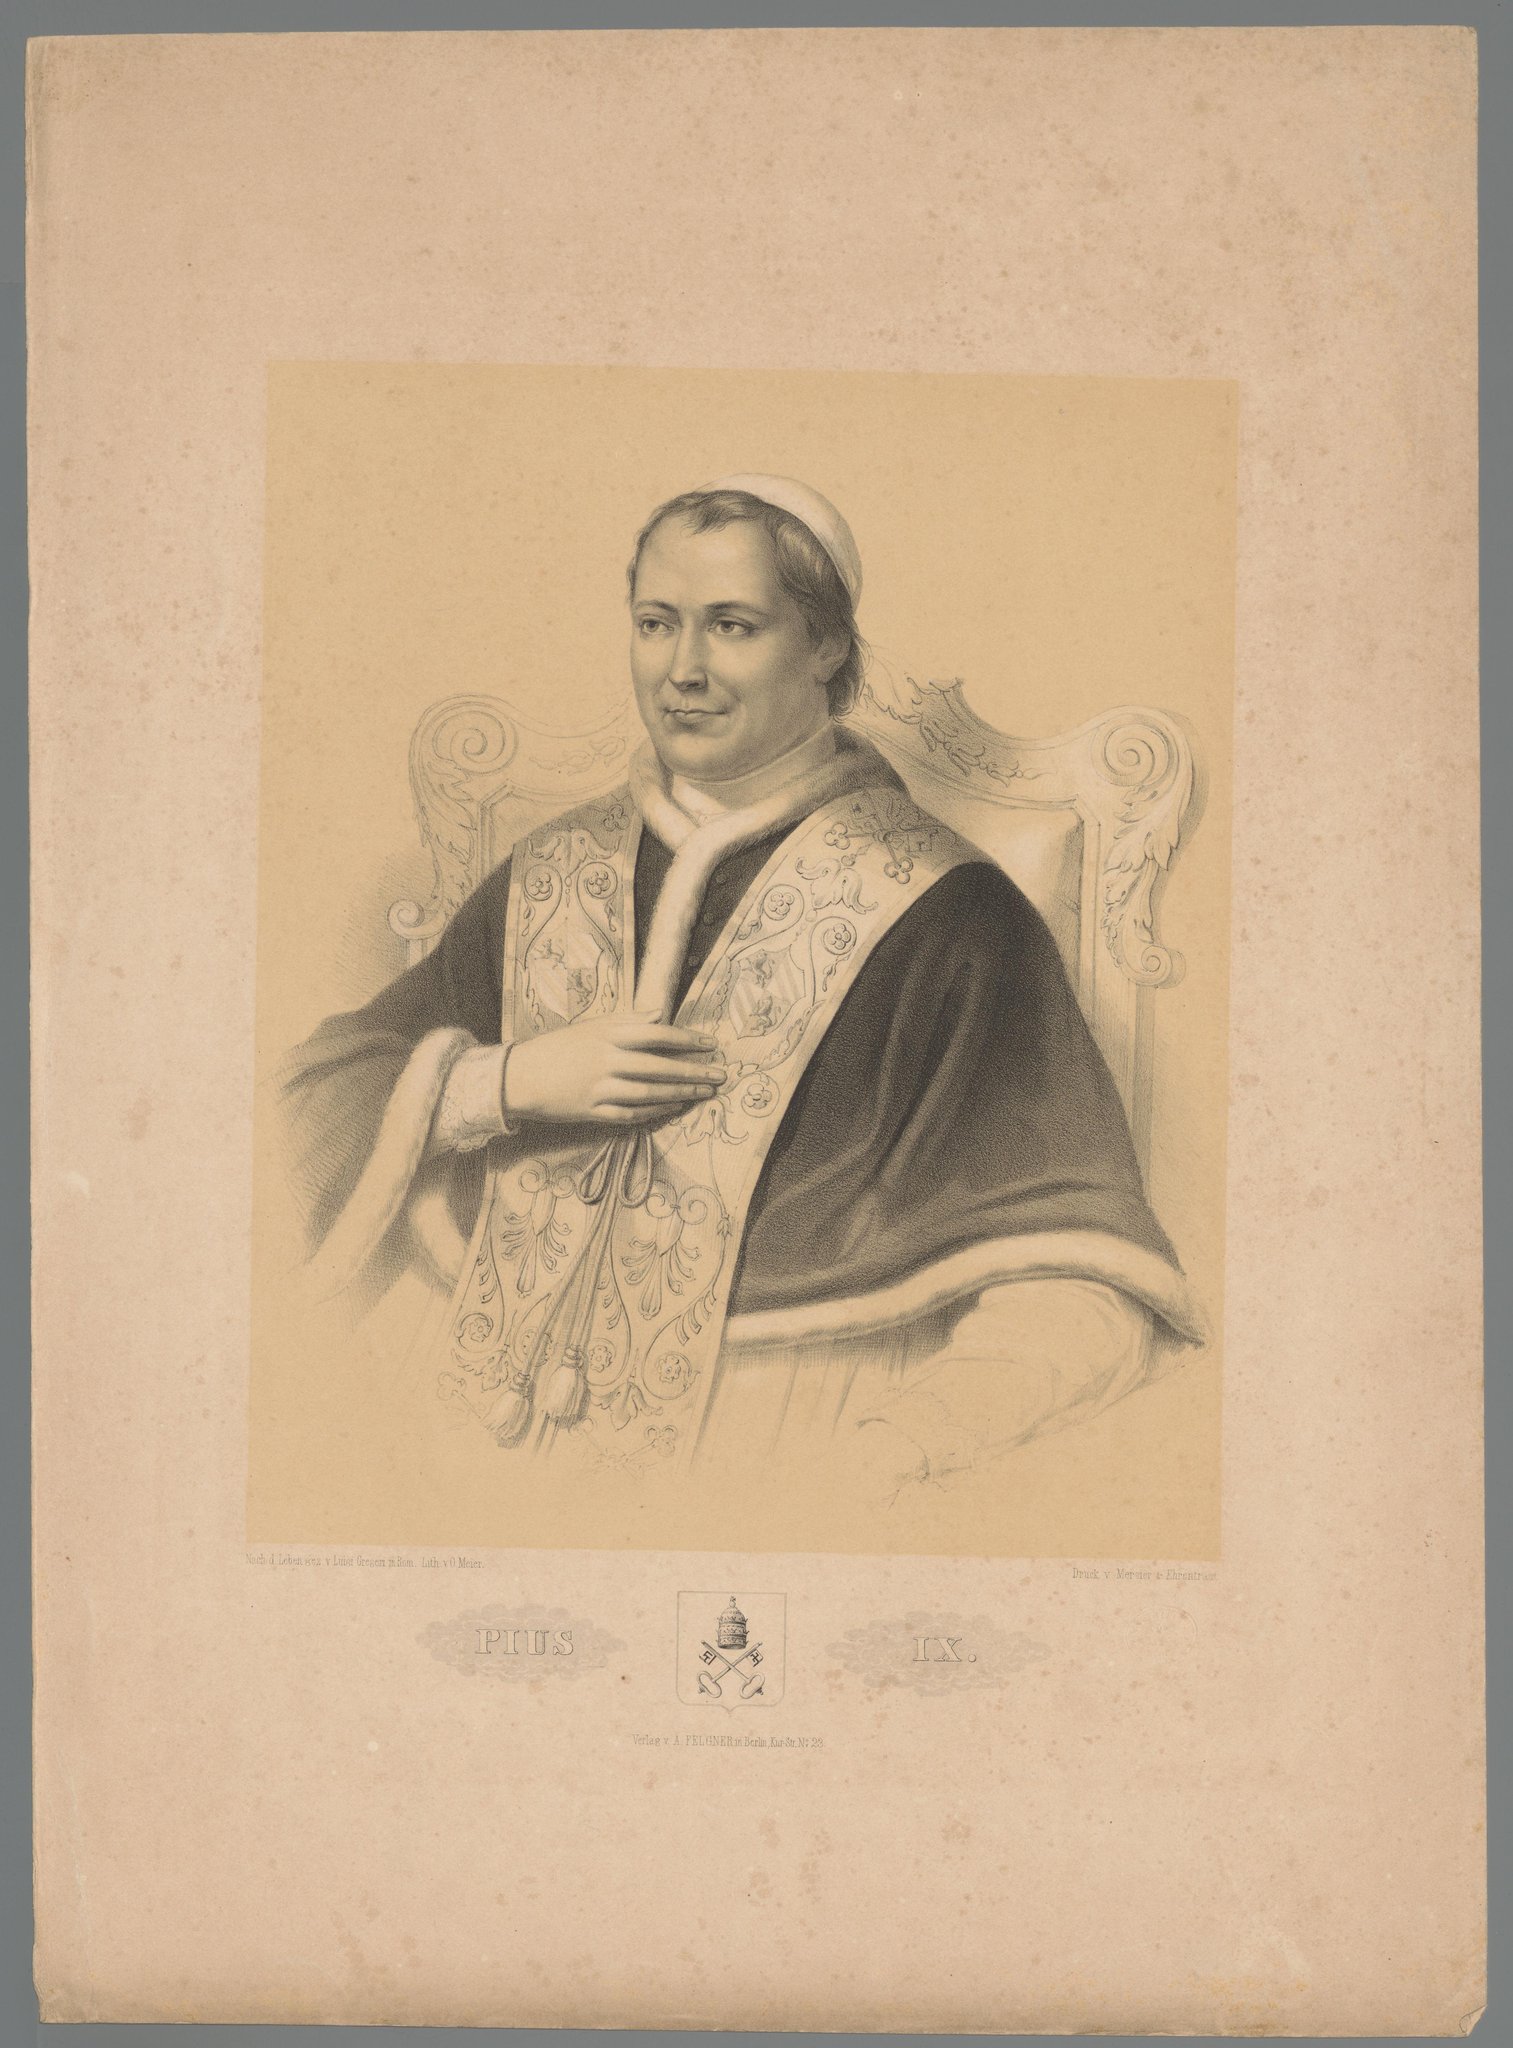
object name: print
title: Portret van Pius IX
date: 1820-1880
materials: paper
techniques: tone lithography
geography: berlin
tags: rome, historical persons, pope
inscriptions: collector's mark: Lugt 2228